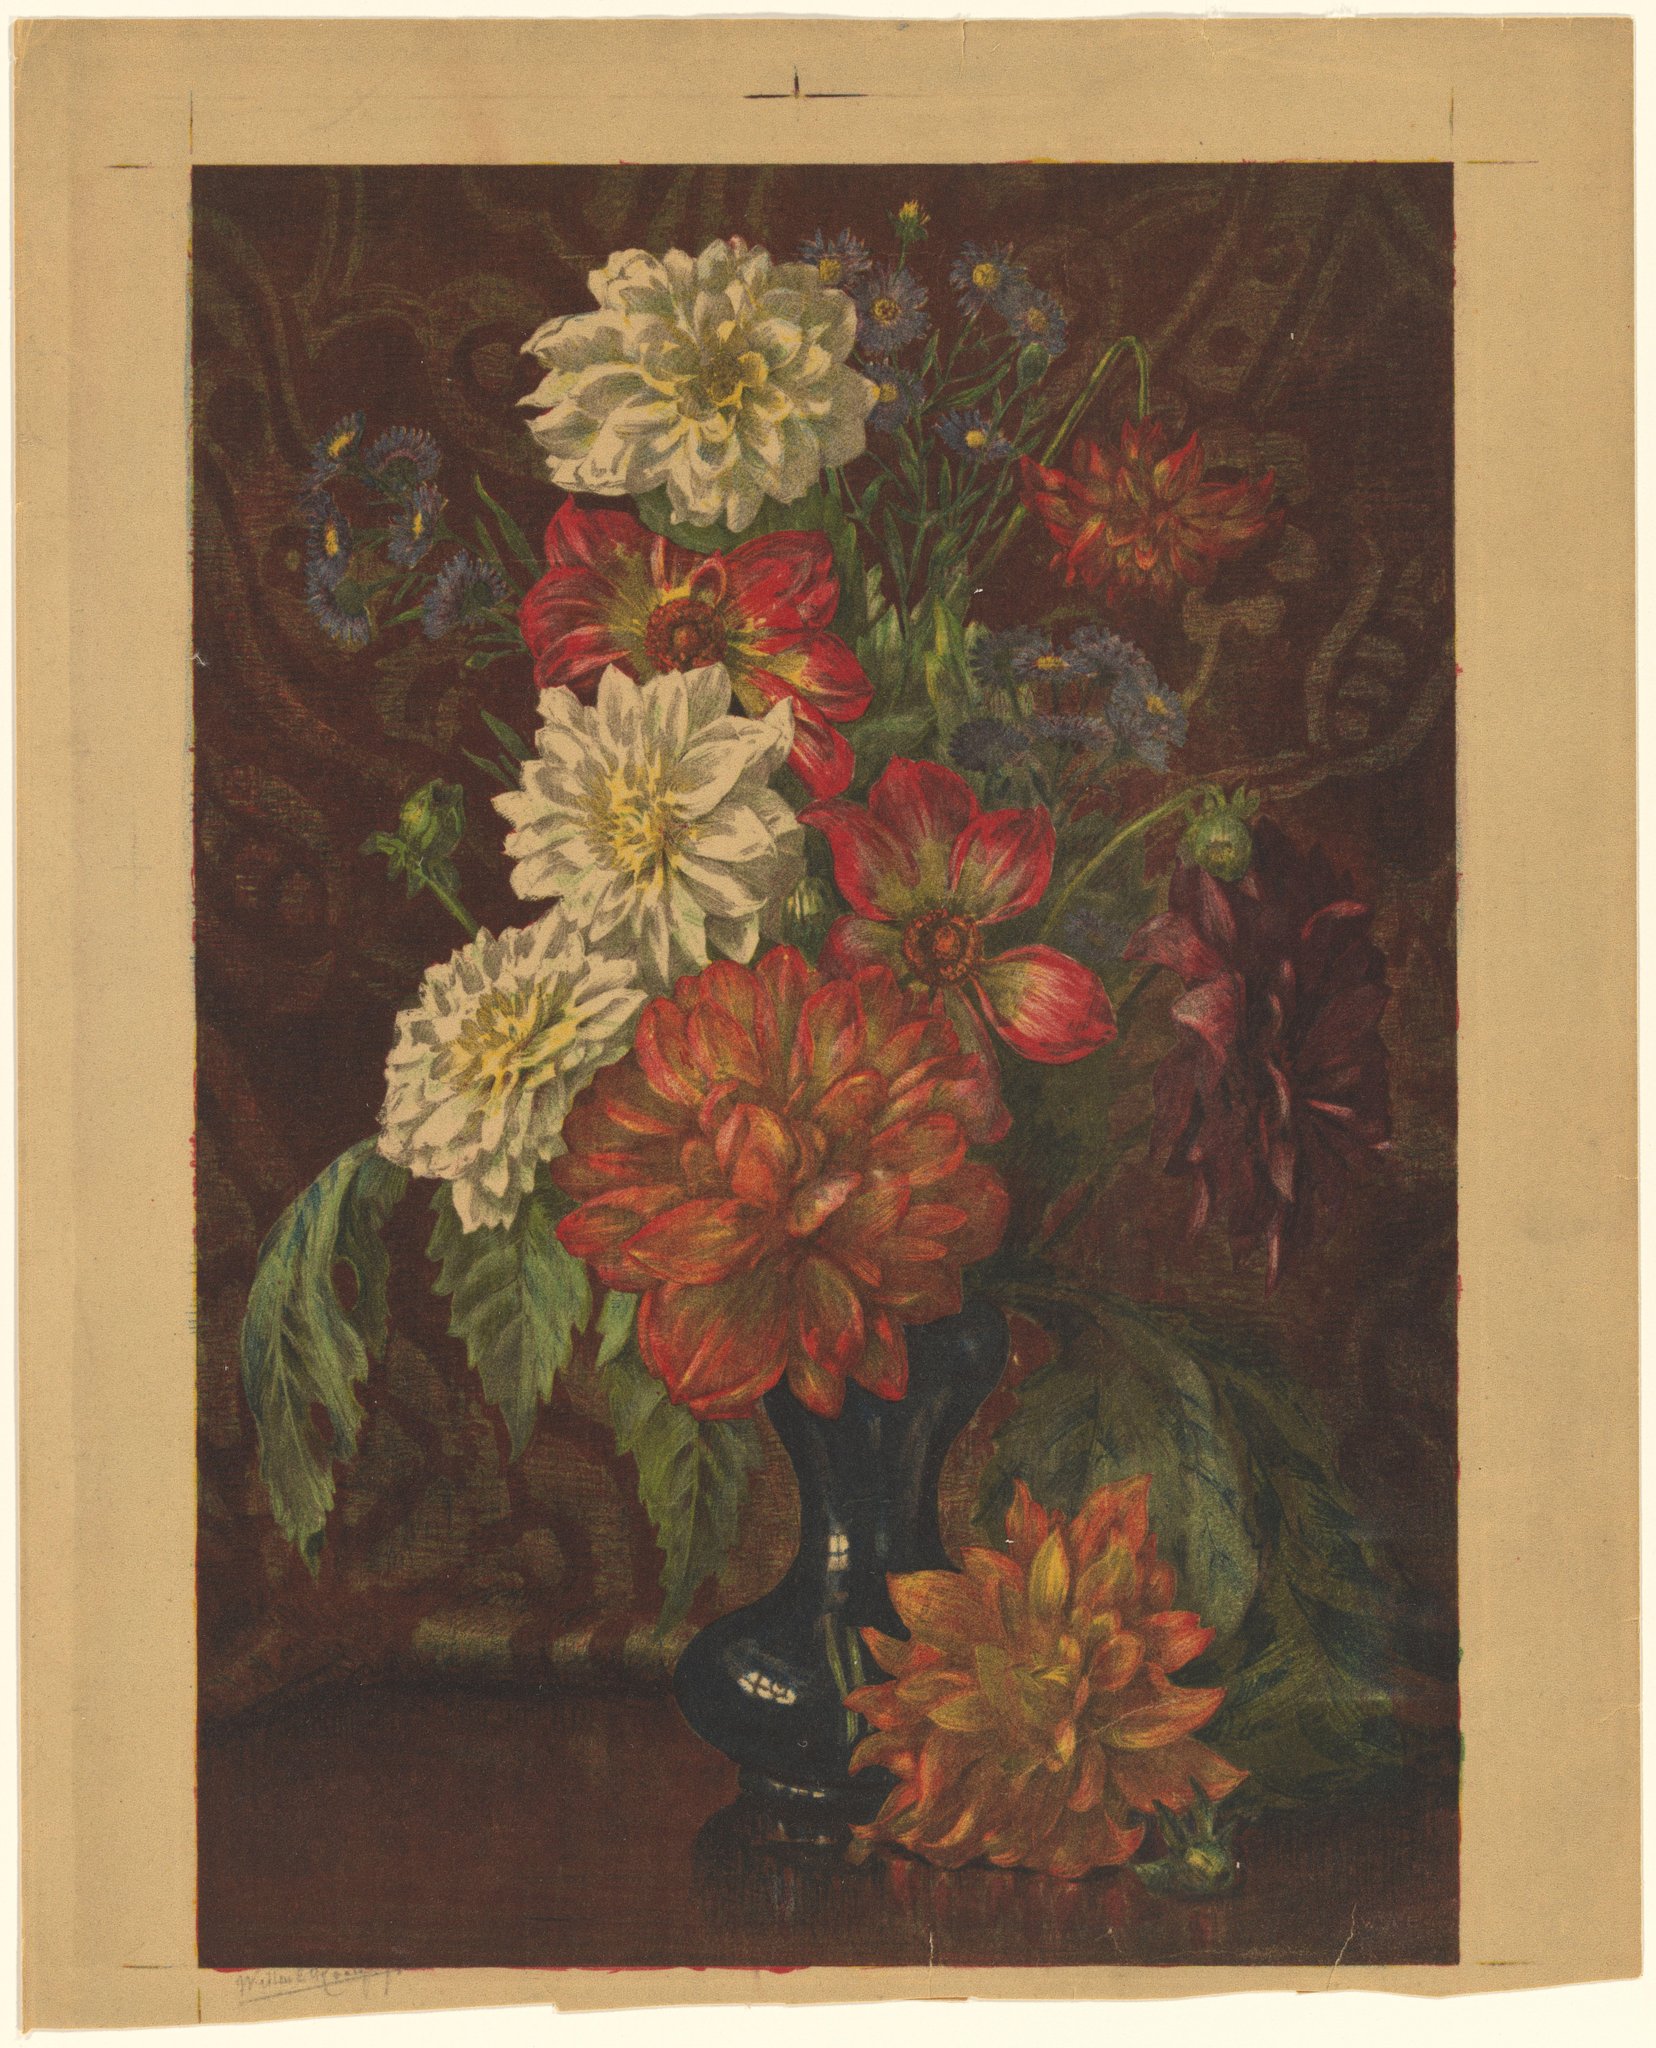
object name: print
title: Vaas met dahlia's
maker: willem roelofs (ii)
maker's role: draughtsman, painter, print maker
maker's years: 1874-1940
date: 1884-1931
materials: paper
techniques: lithograph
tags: flowers, flowers in a vase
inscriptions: collector's mark: Lugt 2228